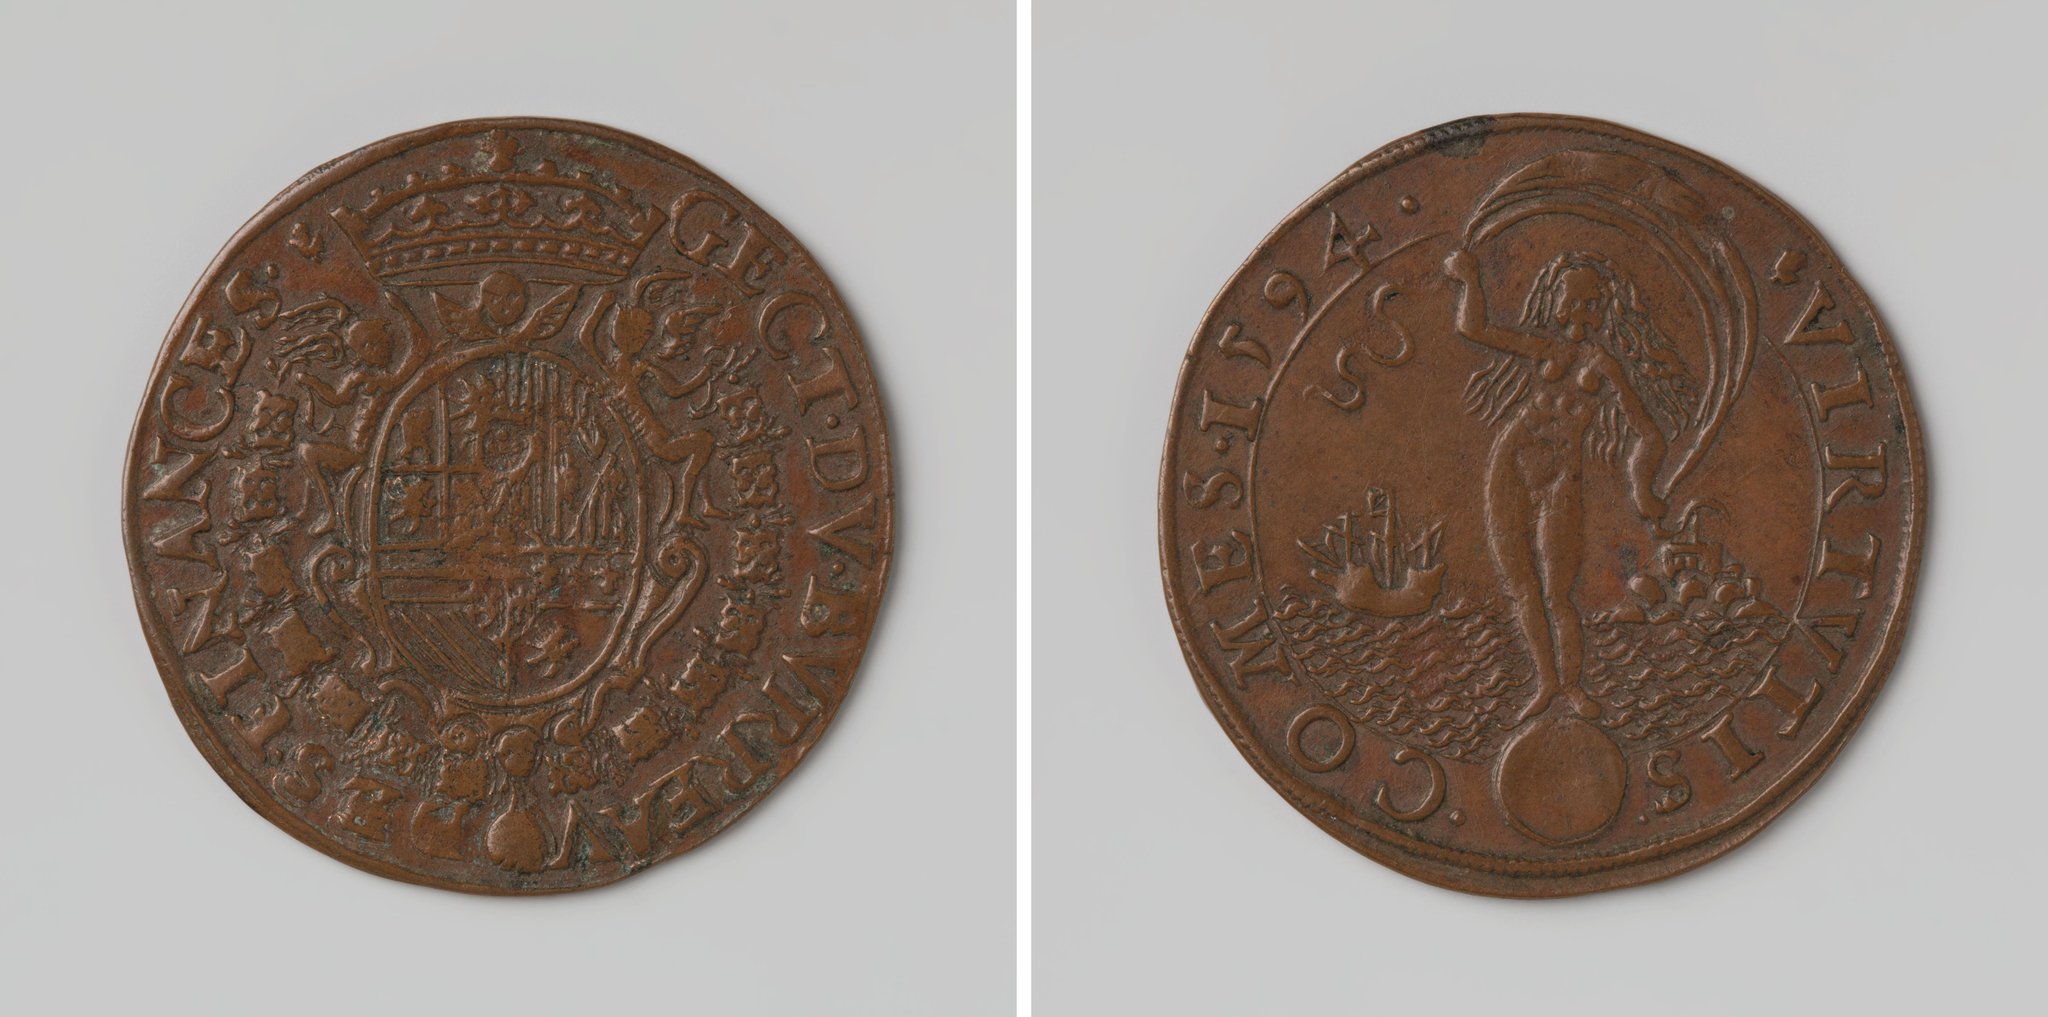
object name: jeton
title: Raad van Financiën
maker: Anonymous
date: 1594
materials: copper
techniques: striking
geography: antwerp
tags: philip ii of spain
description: Koperen penning. Voorzijde: gekroond wapenschild in cartouche, geflankeerd door twee engeltjes, omhangen met de orde van het Gulden Vlies binnen omschrift. Keerzijde: naakte vrouw met sluier boven hoofd, voorstellende Fortuin, staande op bol in zee binnen omschrift